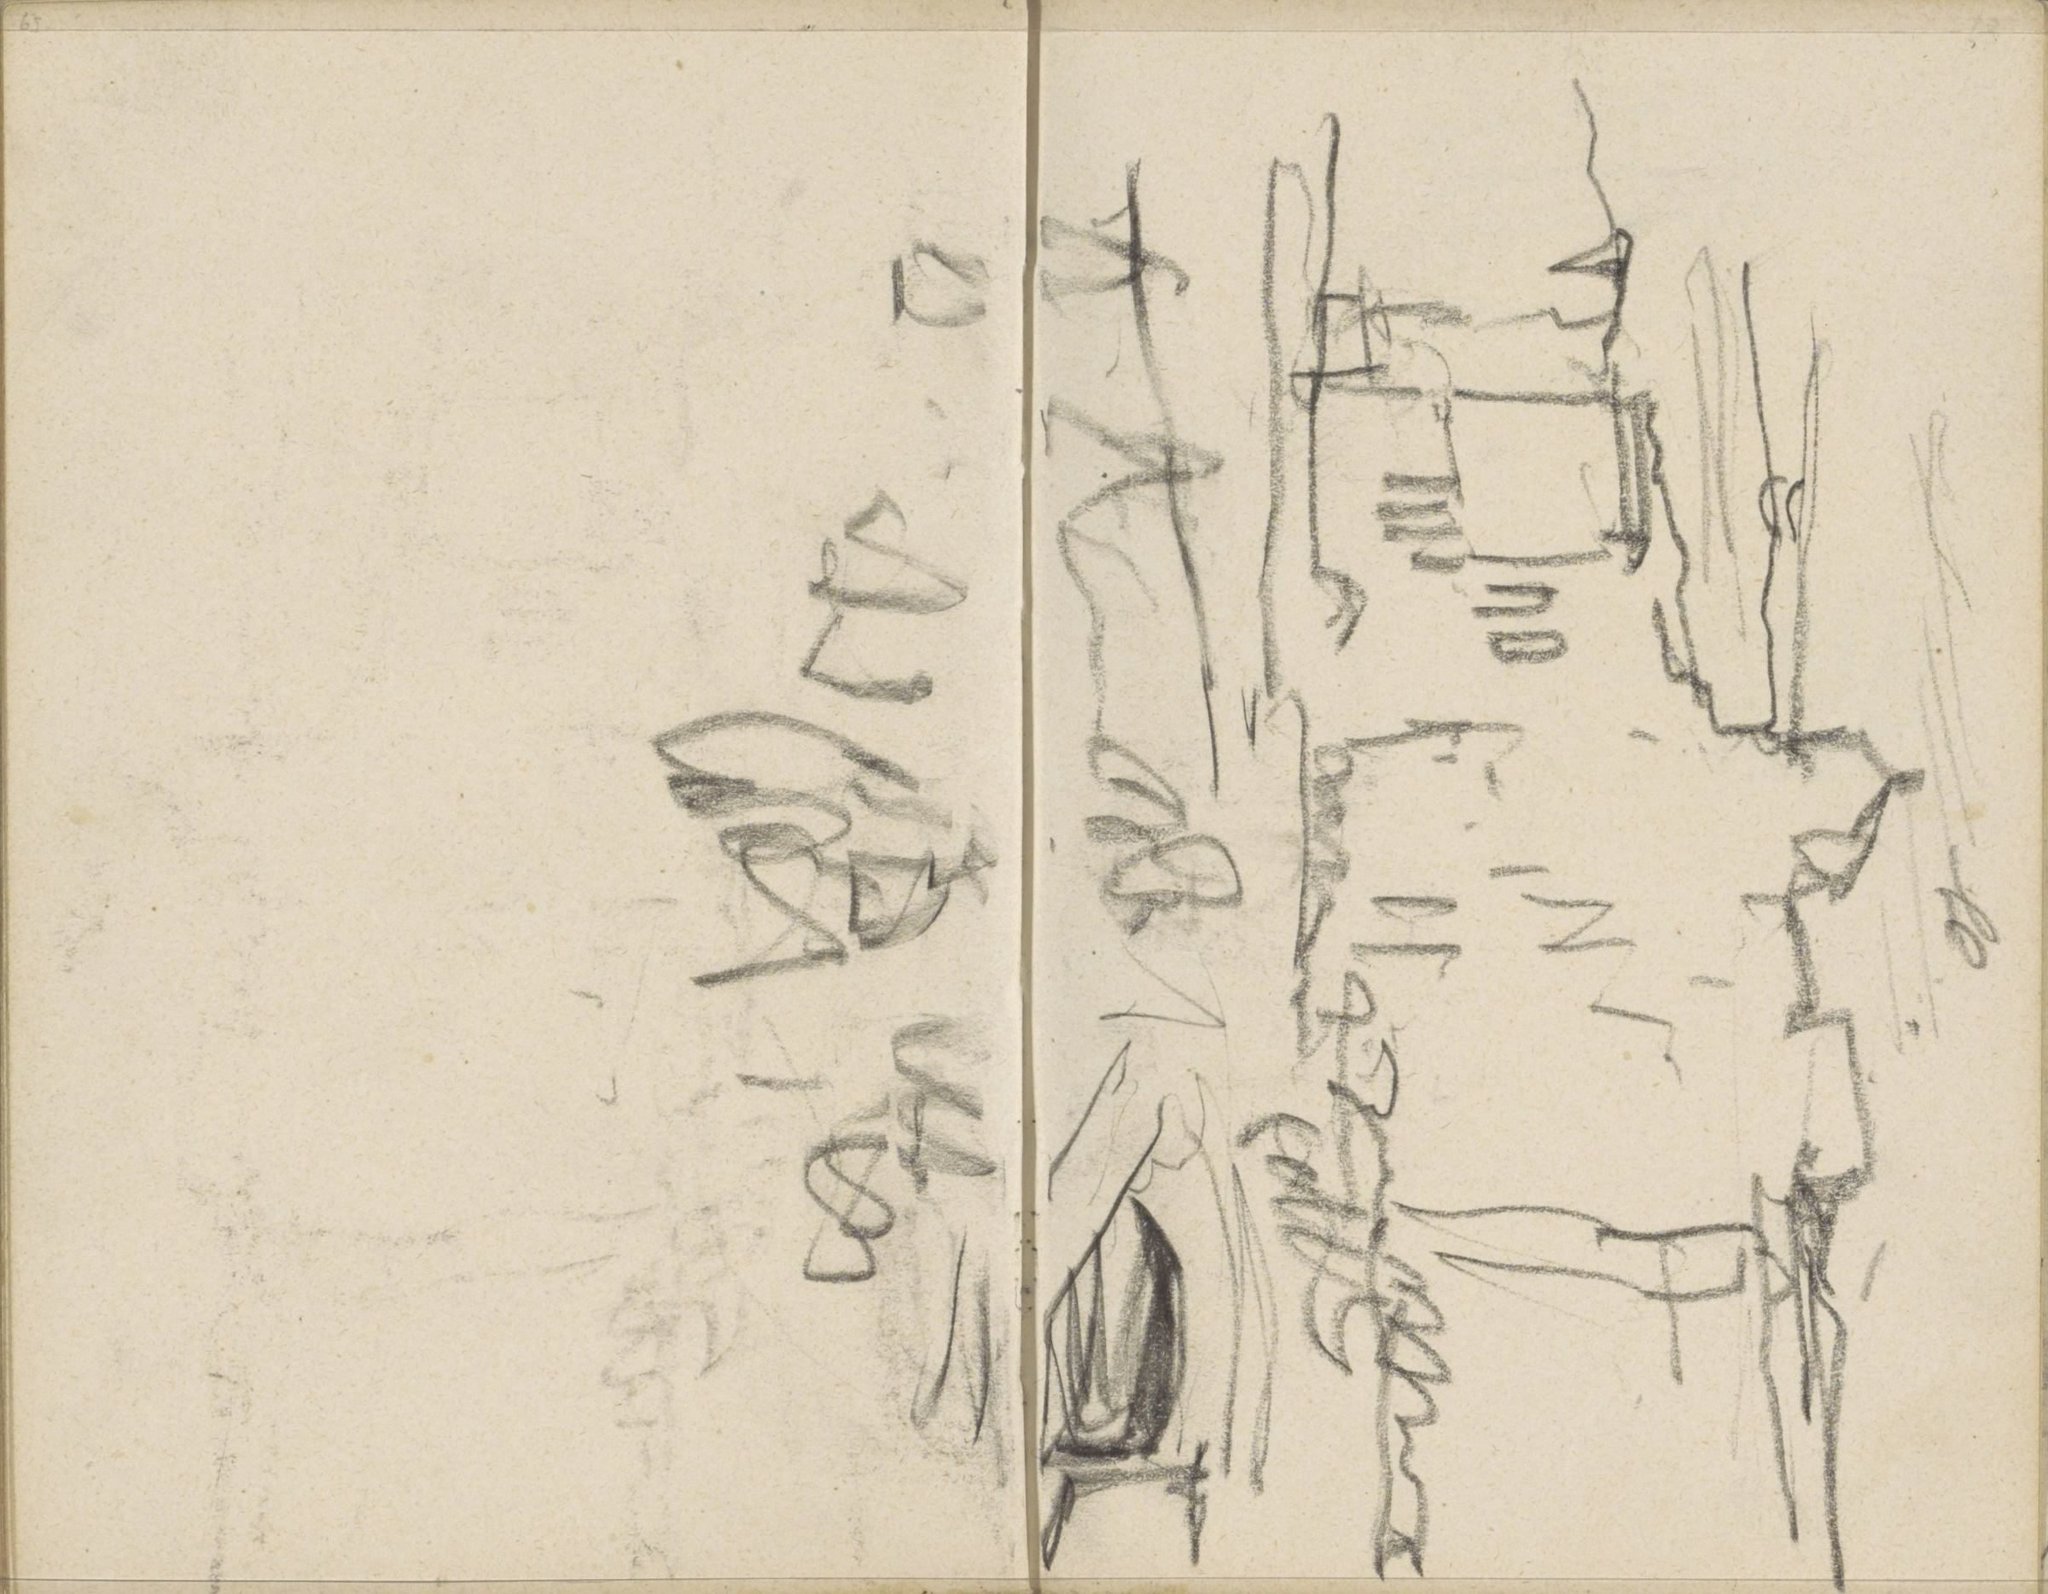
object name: sketchbook leaf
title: Gezicht in Amsterdam, mogelijk het Rokin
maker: george hendrik breitner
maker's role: draughtsman, painter, print maker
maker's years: 1857-1923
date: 1909-1912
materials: chalk, paper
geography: amsterdam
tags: urban housing, bridge in city across river, canal, etc.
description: Gezicht in Amsterdam, mogelijk het Rokin. Pagina 65 en pagina 66 uit een schetsboek met 46 bladen vervaardigd te Amsterdam.